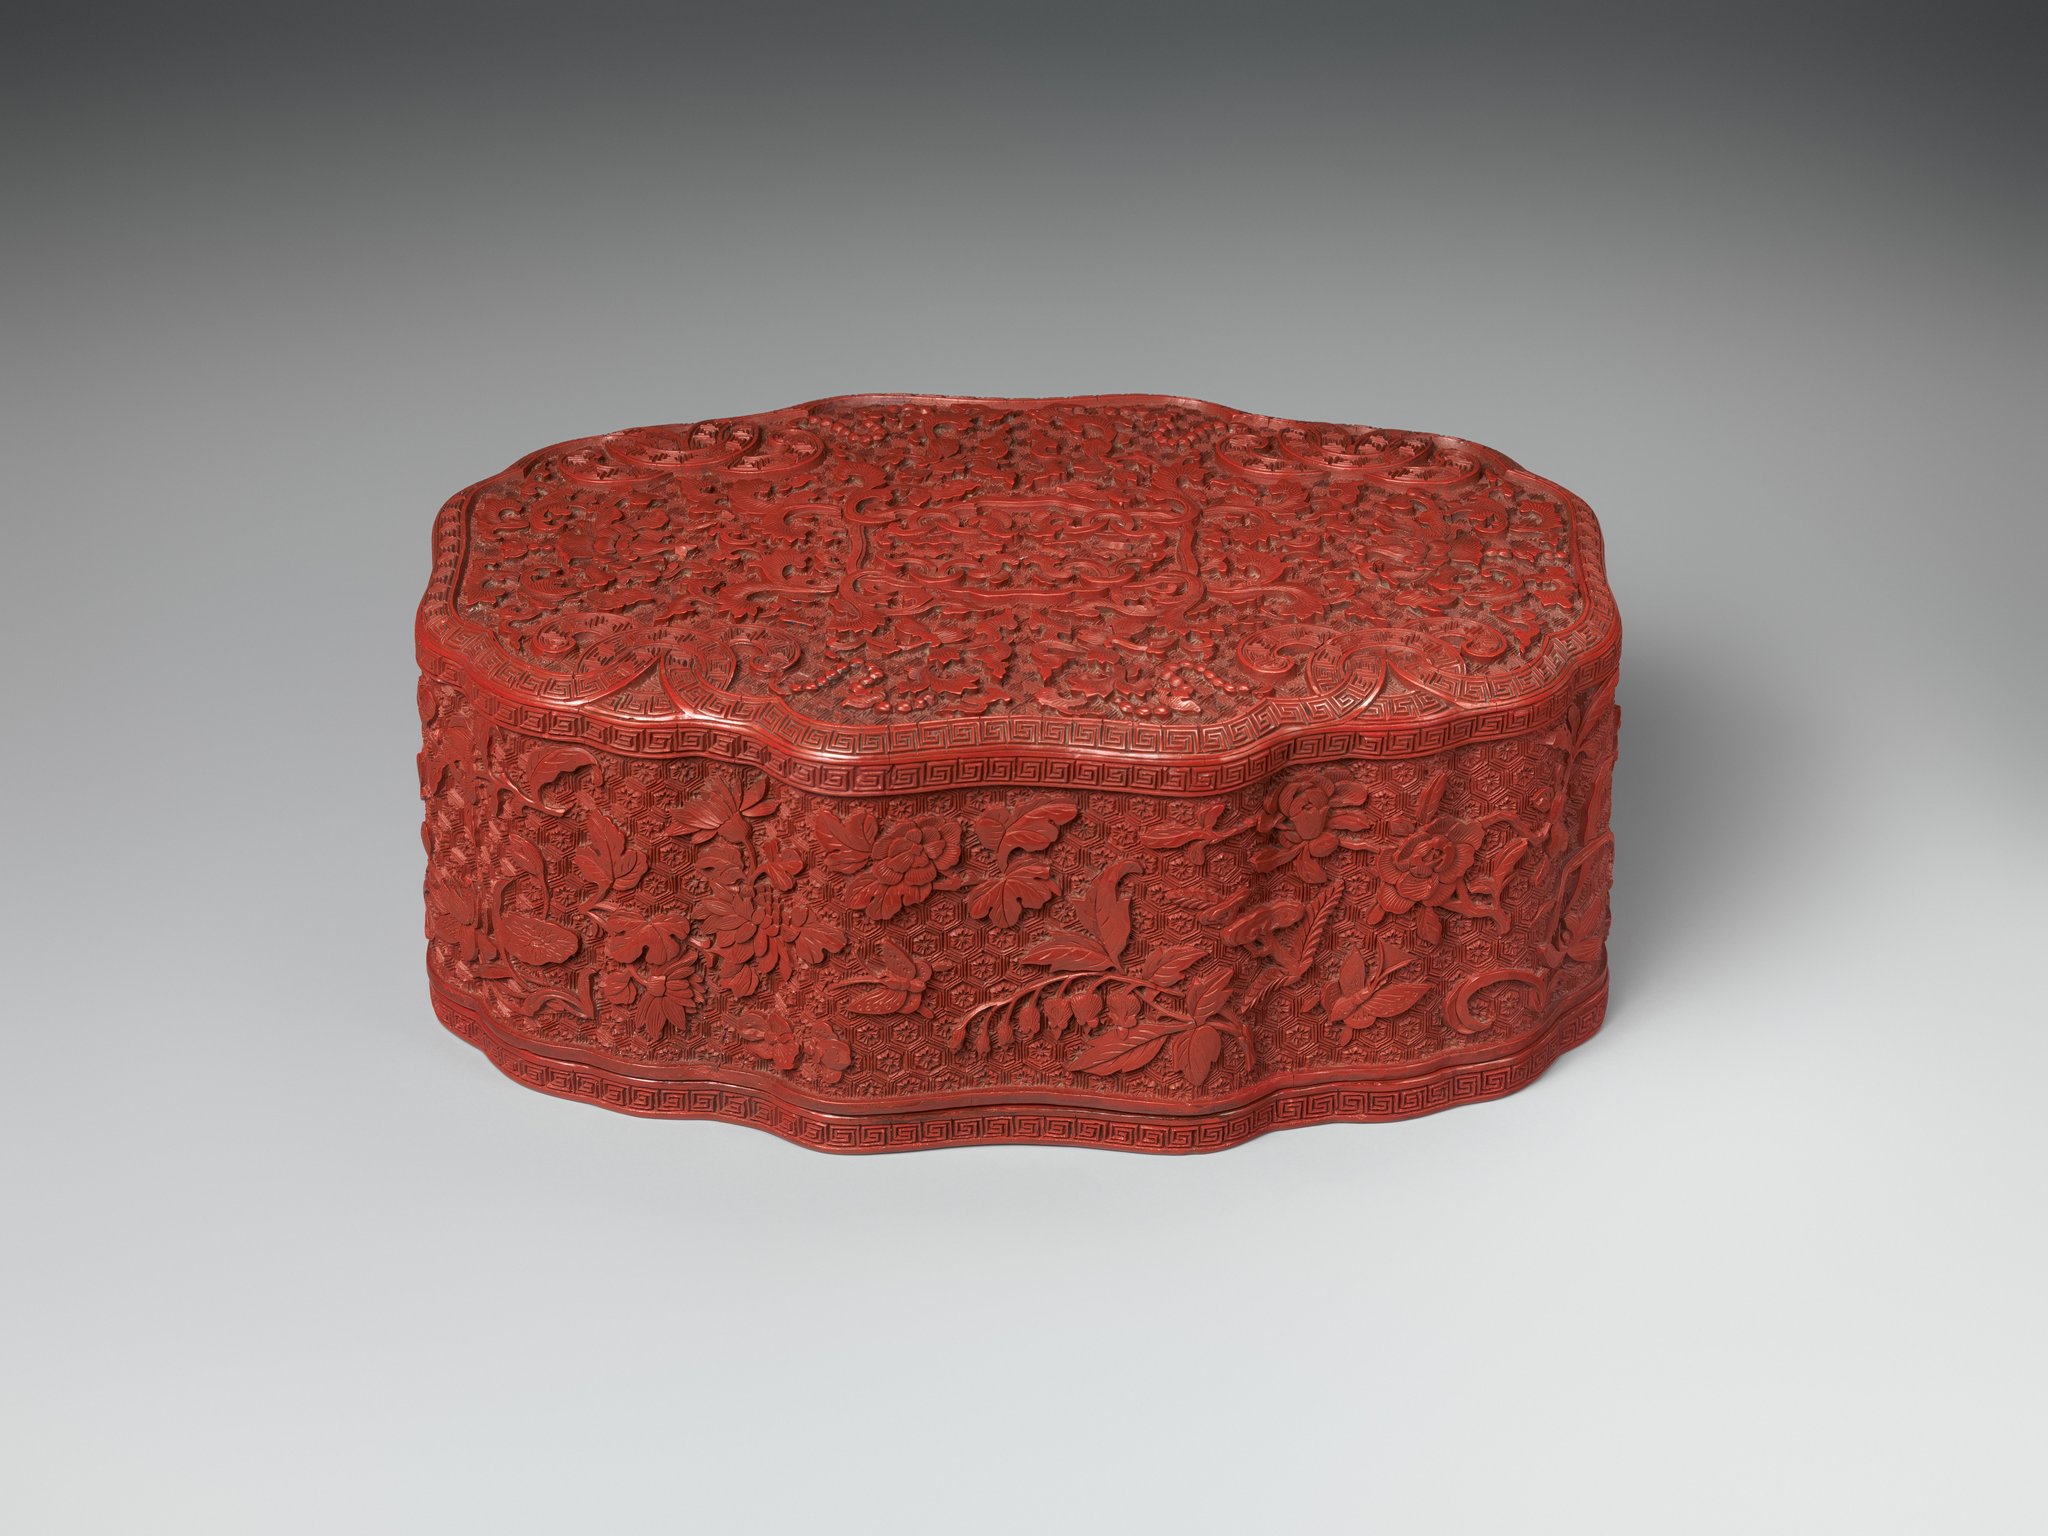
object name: set of box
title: Set of boxes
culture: chinese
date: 1801-1900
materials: lacquer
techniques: carving, gilding, painting